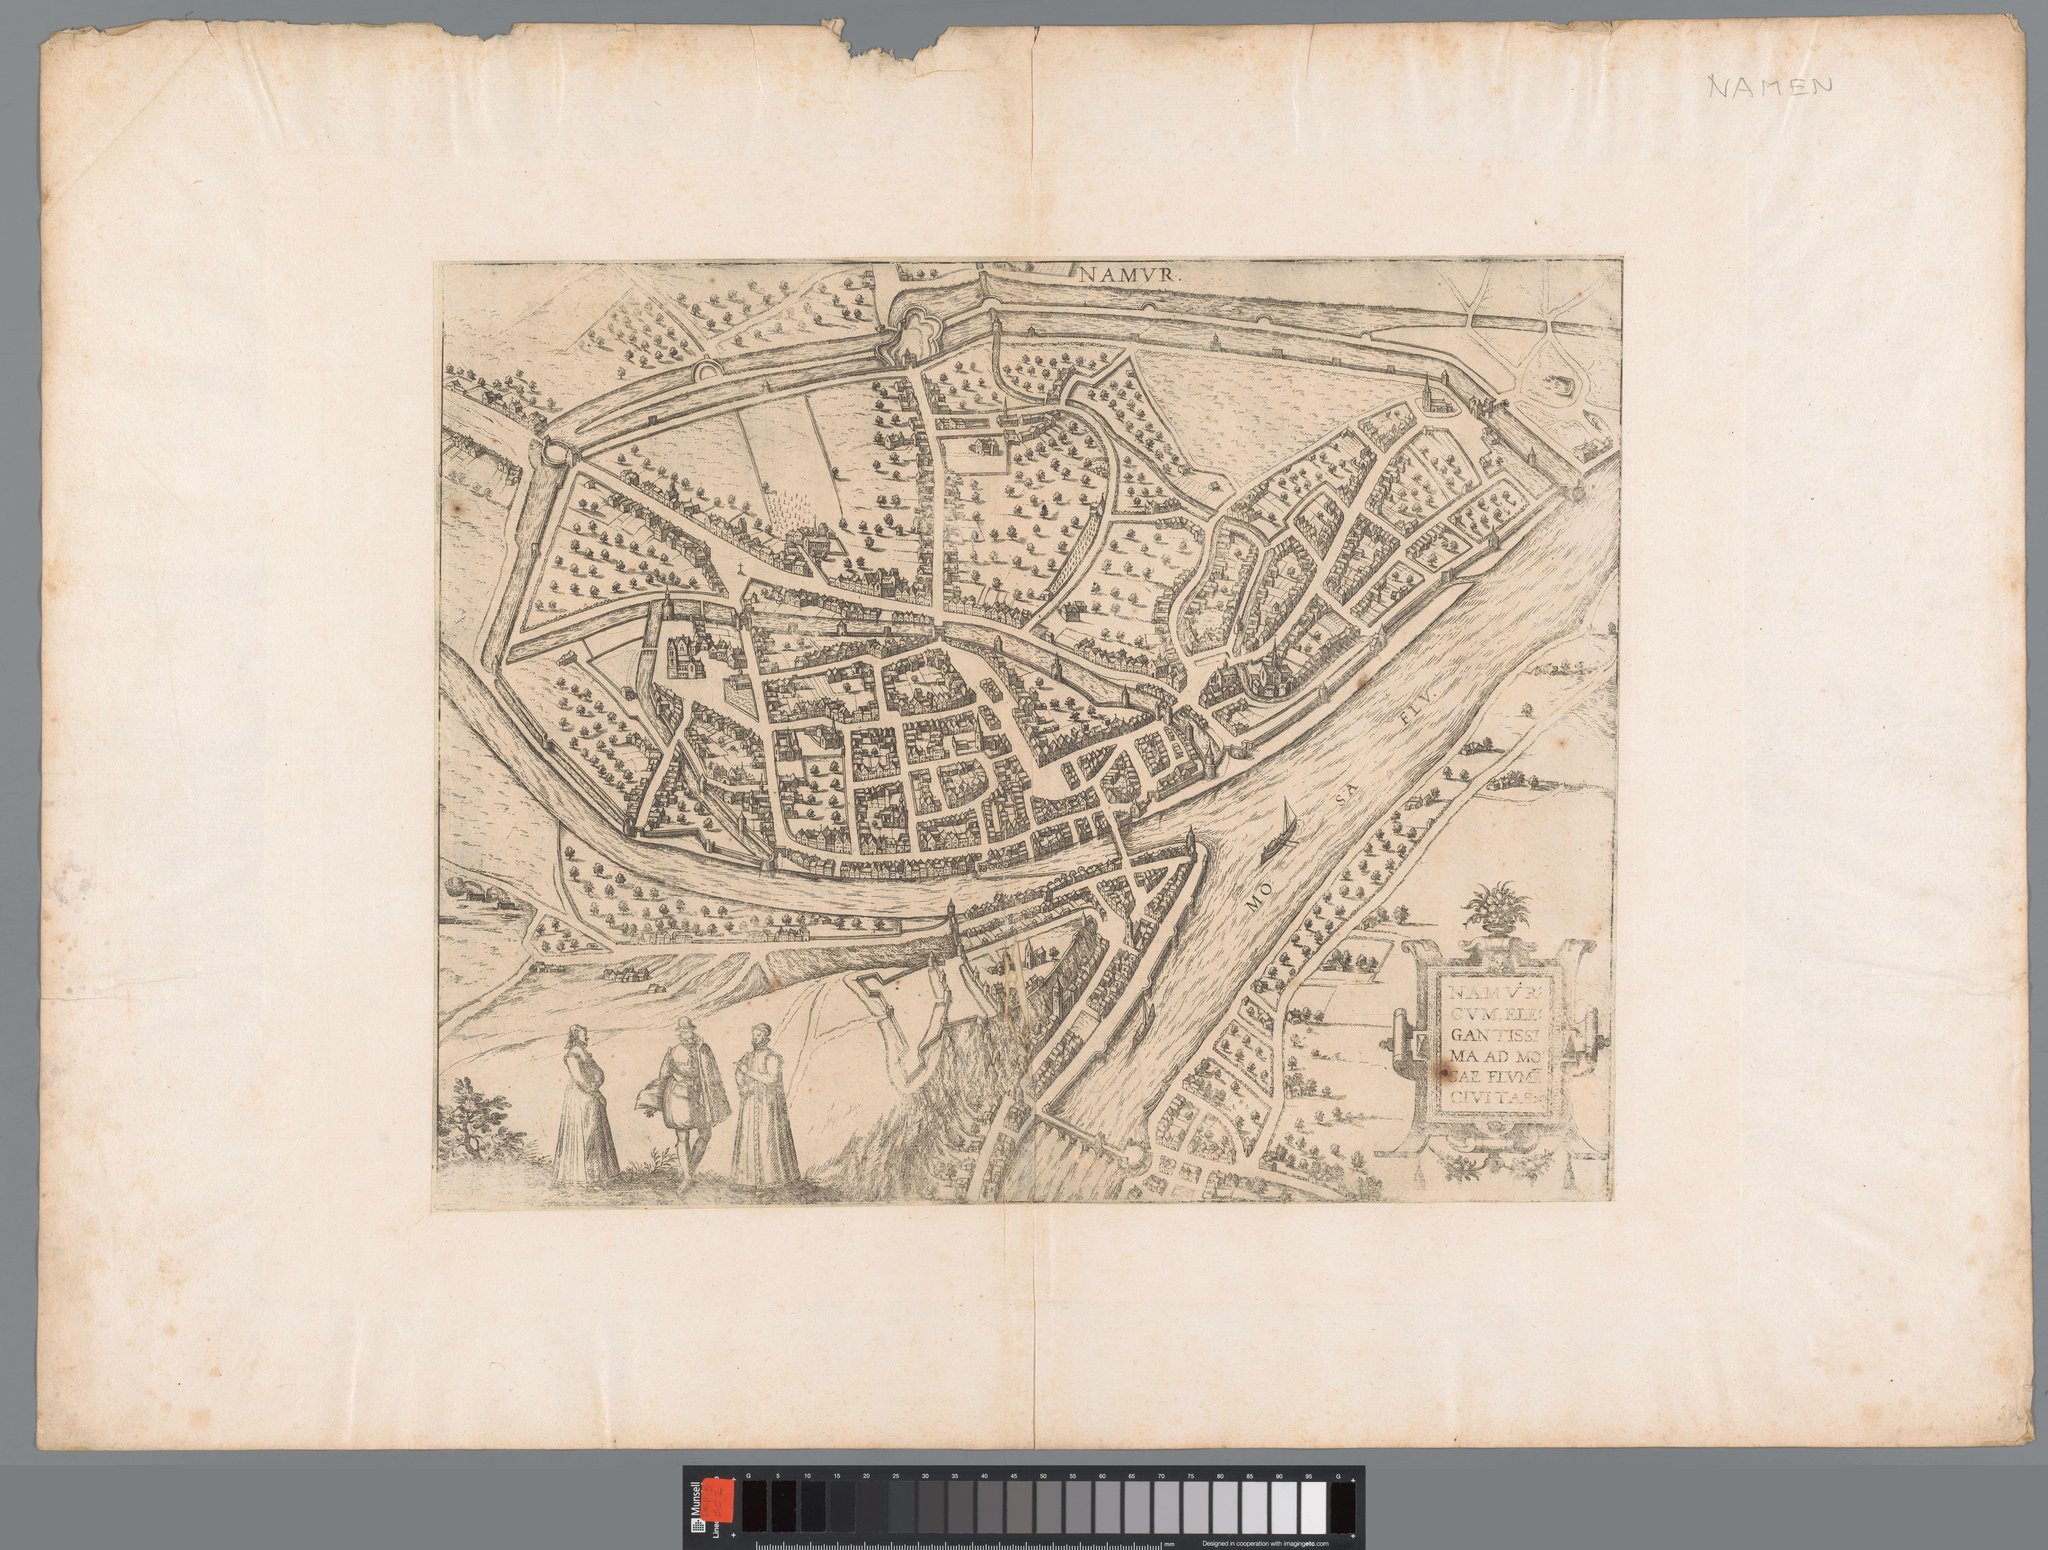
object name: area plan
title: Plattegrond van Namen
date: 1616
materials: paper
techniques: etching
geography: cologne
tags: maps of cities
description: Prent uit: Braun, Georg. Civitates orbis terrarum (...), 6 dln. Keulen: Peter von Brachel, 1612-1616, dl. 3, nr. 32.